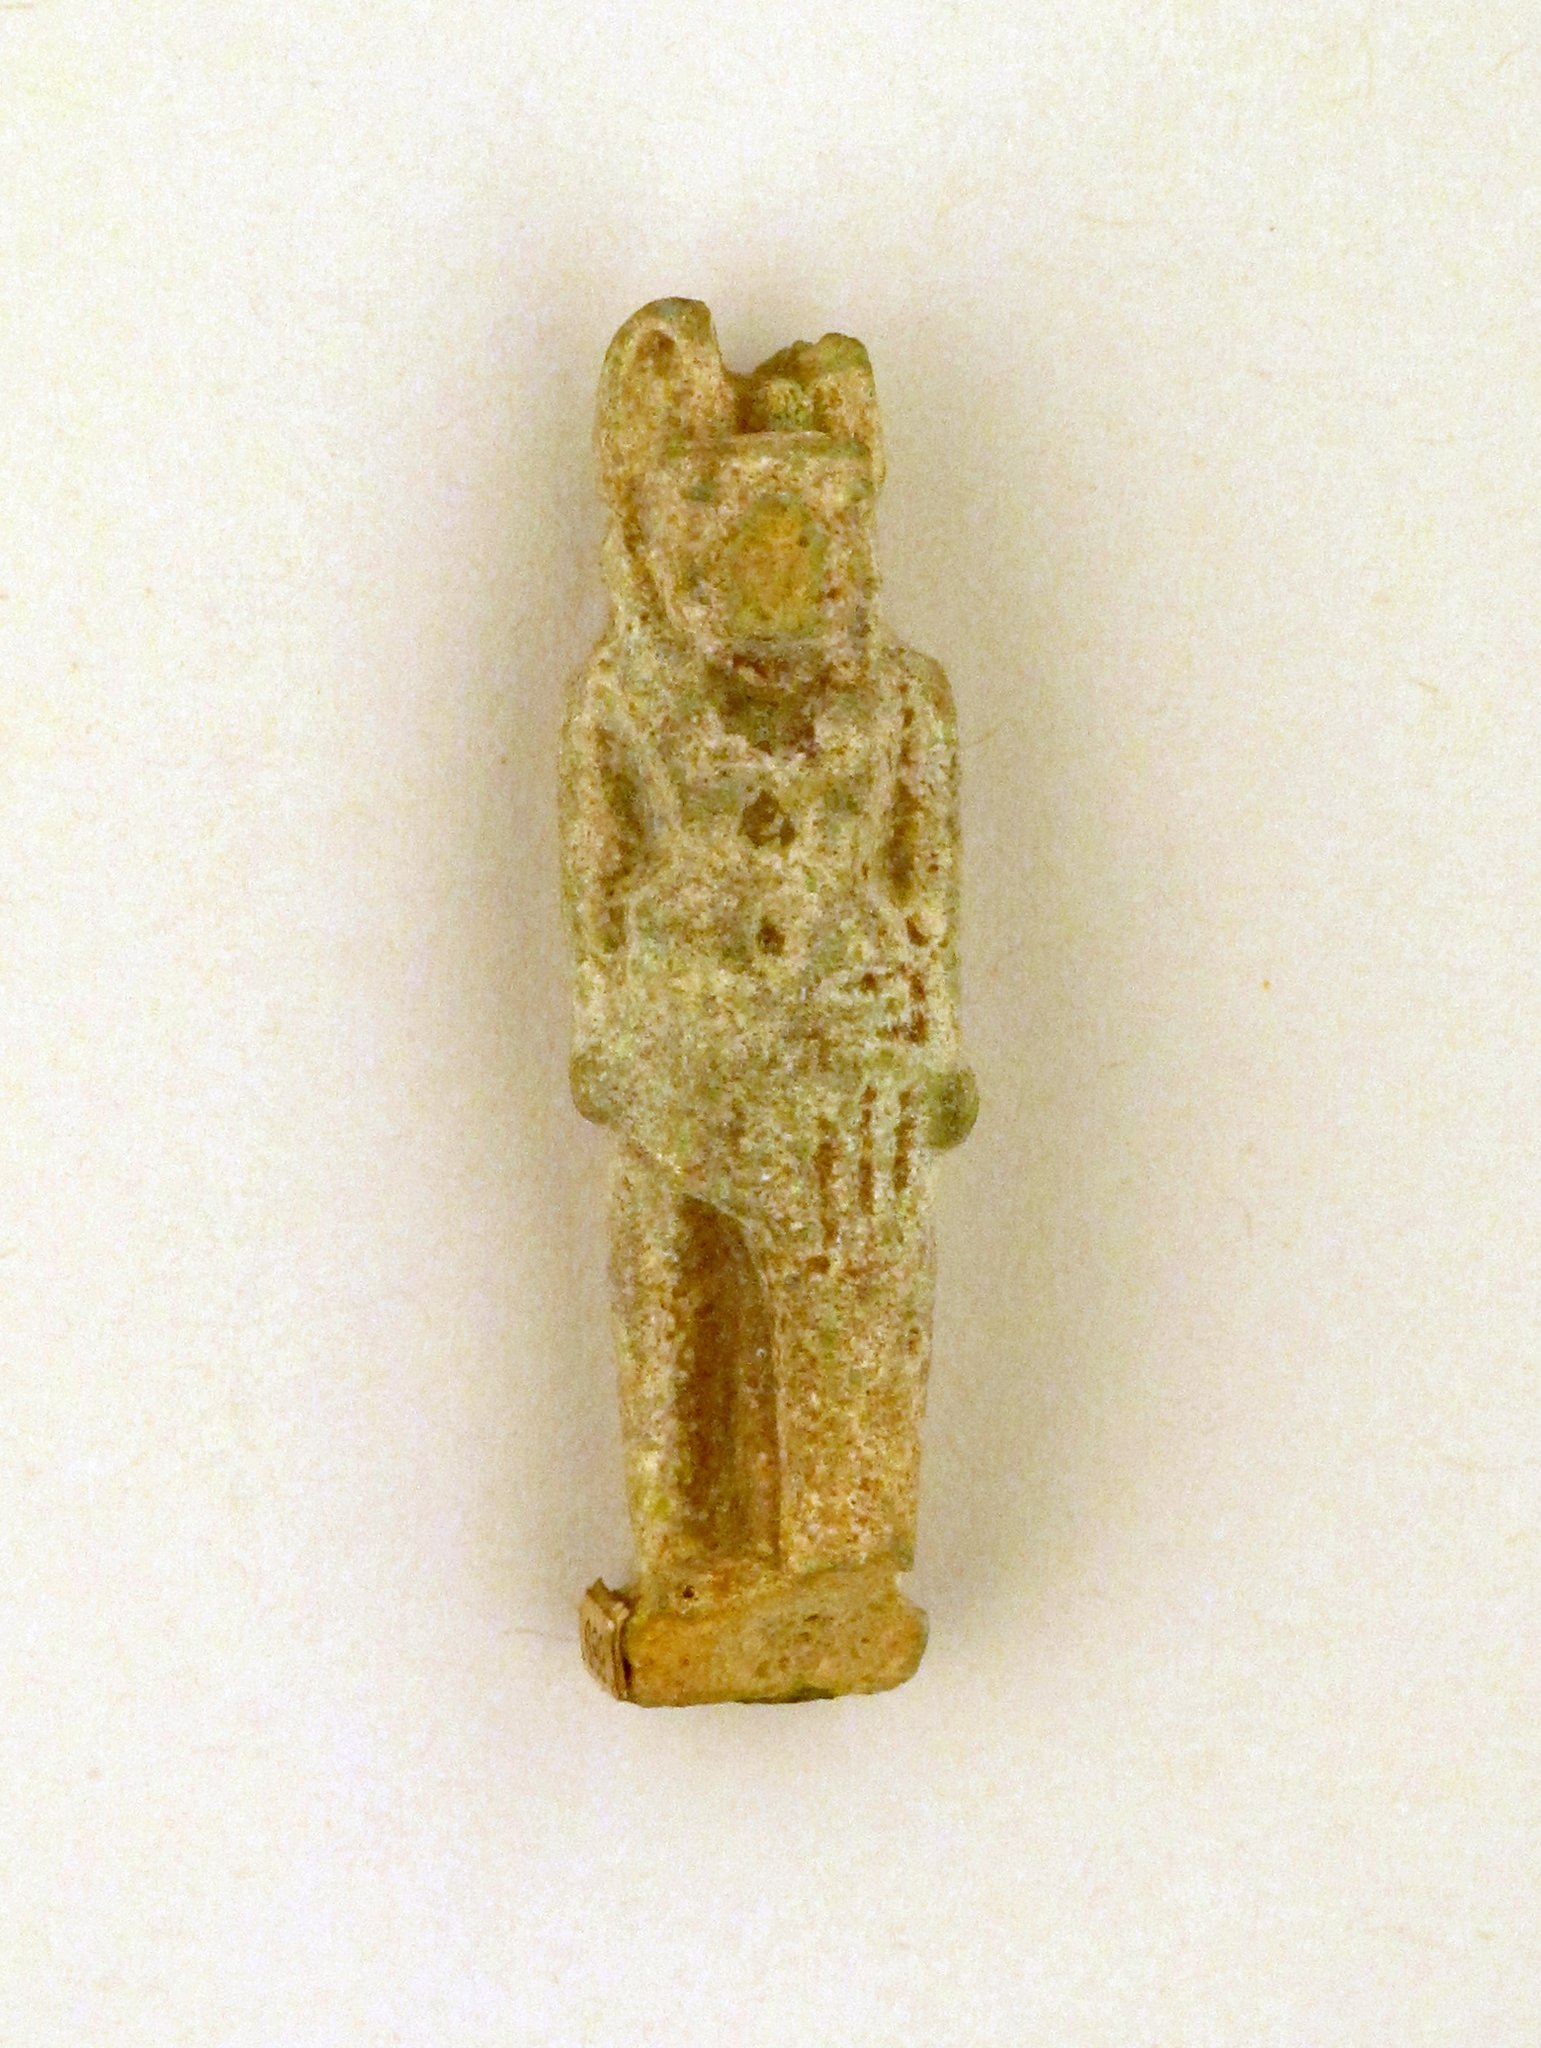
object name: amulet, anubis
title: Faience amulet of a canine-headed Anubis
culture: egyptian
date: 664-334 BCE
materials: faience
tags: anubis